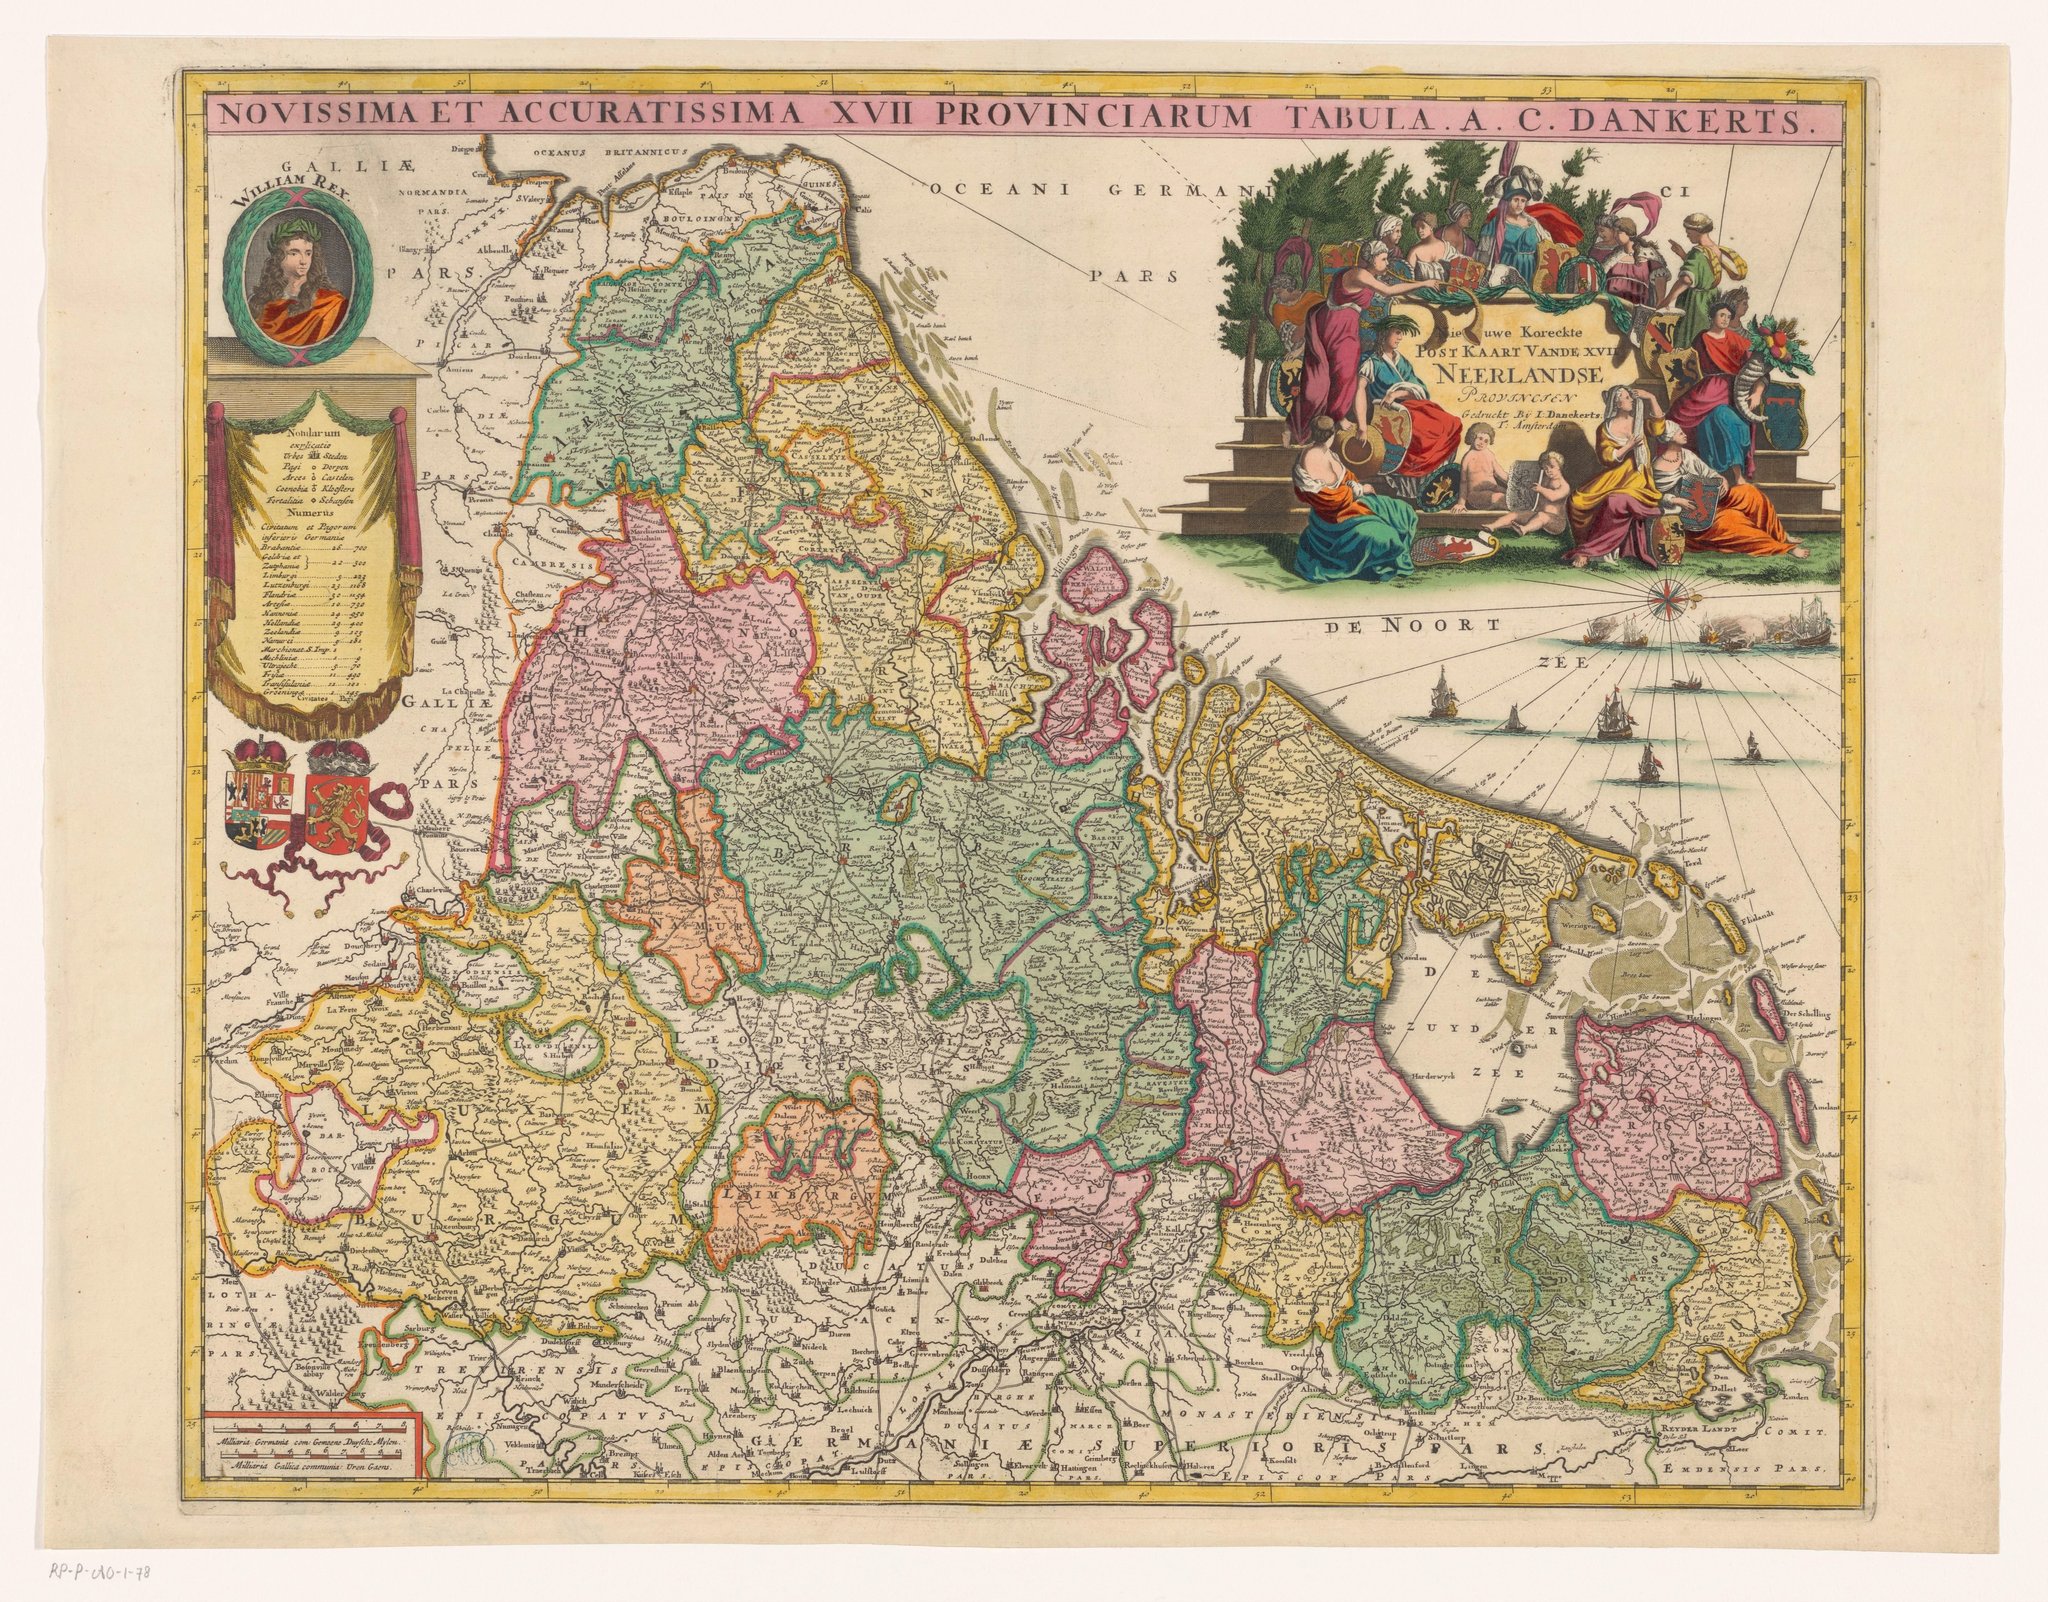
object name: print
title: Kaart van de Zeventien Provinciën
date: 1688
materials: paper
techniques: engraving, etching, hand coloring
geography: amsterdam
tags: the hague, william iii (prince of orange and king of england, scotland, and ireland), coat of arms (as symbol of the state, etc.), maps of separate countries or regions, low countries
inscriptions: collector's mark: Lugt 195, collector's mark: Lugt 2228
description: Linksboven een portret van koning-stadhouder Willem III. Daaronder een cartouche met een overzicht van de provincies, topografische informatie en een legenda. Daaronder het wapen van de Habsburgse koningen van Spanje en het wapen van de Republiek. Rechtsboven de titelcartouche met daaromheen vrouwelijke personificaties van de Zeventien Provinciën met bijhorende wapens. Linksonder twee schaalstokken: 8 milliaria Germania com: gemeene Duytsche mylen; 10 milliaria Gallica communia: uren gaens. Gradenverdeling langs de randen. Oriëntatie: noorden rechts.